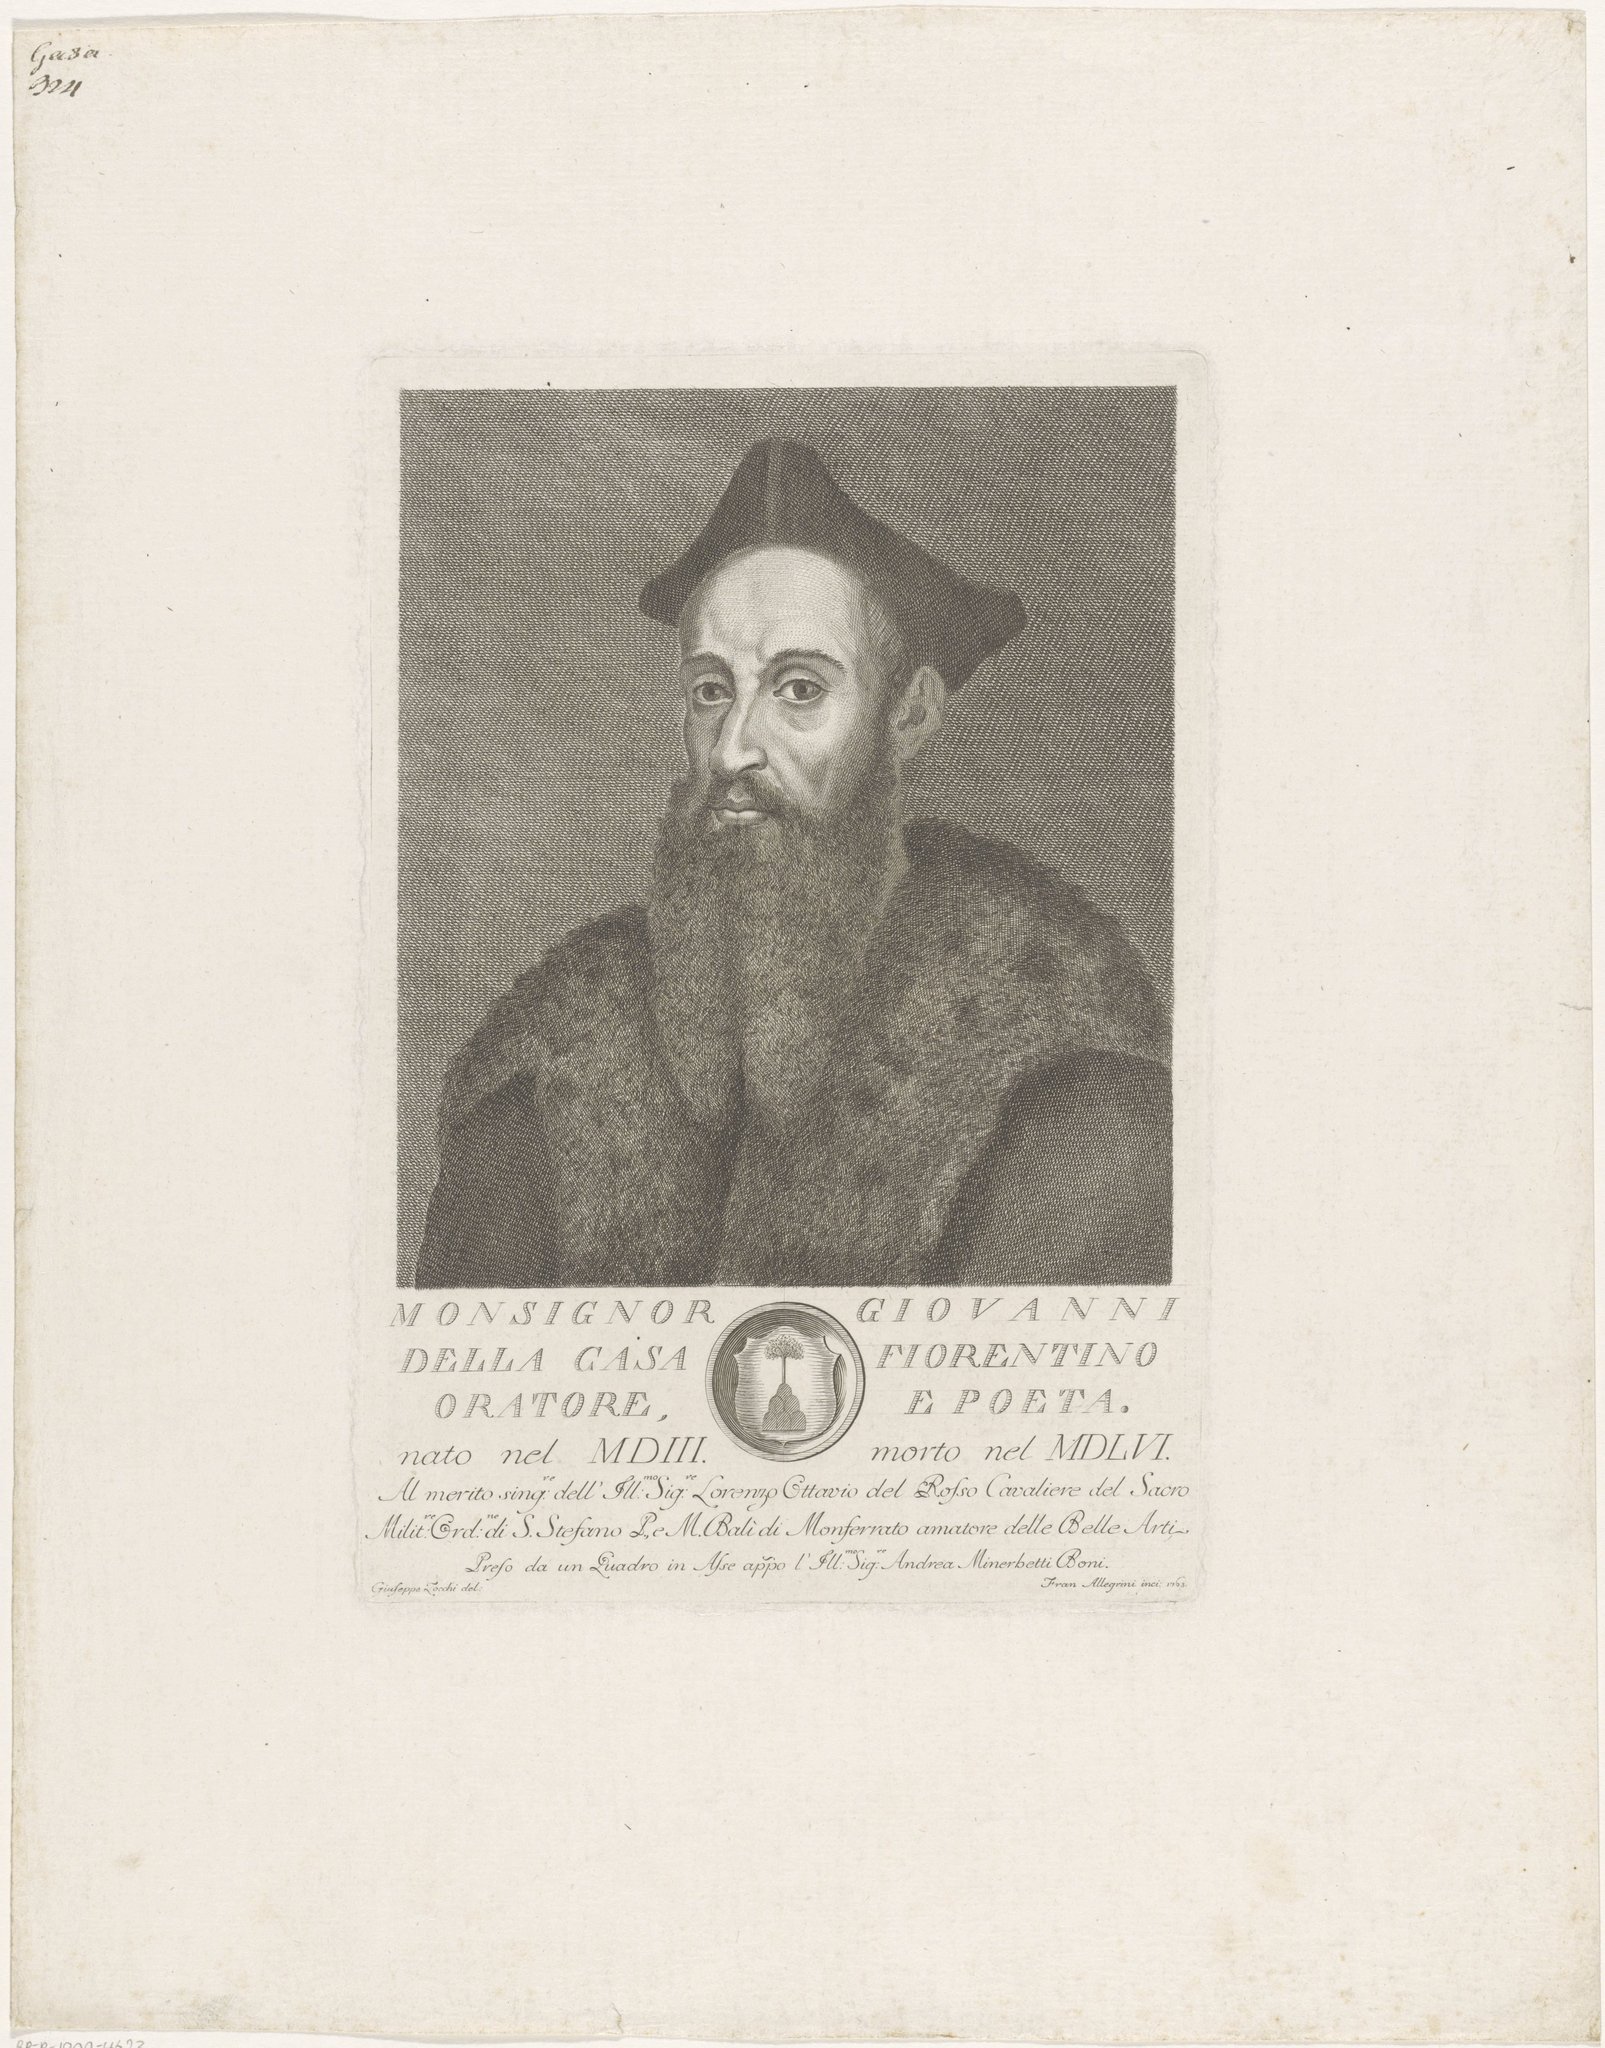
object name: print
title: Portretten van beroemde Italianen met wapenschild in ondermarge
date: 1763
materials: paper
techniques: engraving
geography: italy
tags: historical persons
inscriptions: collector's mark: Lugt 2228, inscription: ‘Casa / 324’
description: Deze prent maakt deel uit van een reeks portretprenten van onbekende omvang. De prenten zijn gemaakt door meedere prentmakers, onder wie Francesco Allegrini en Carlo en Raimondo Faucci.